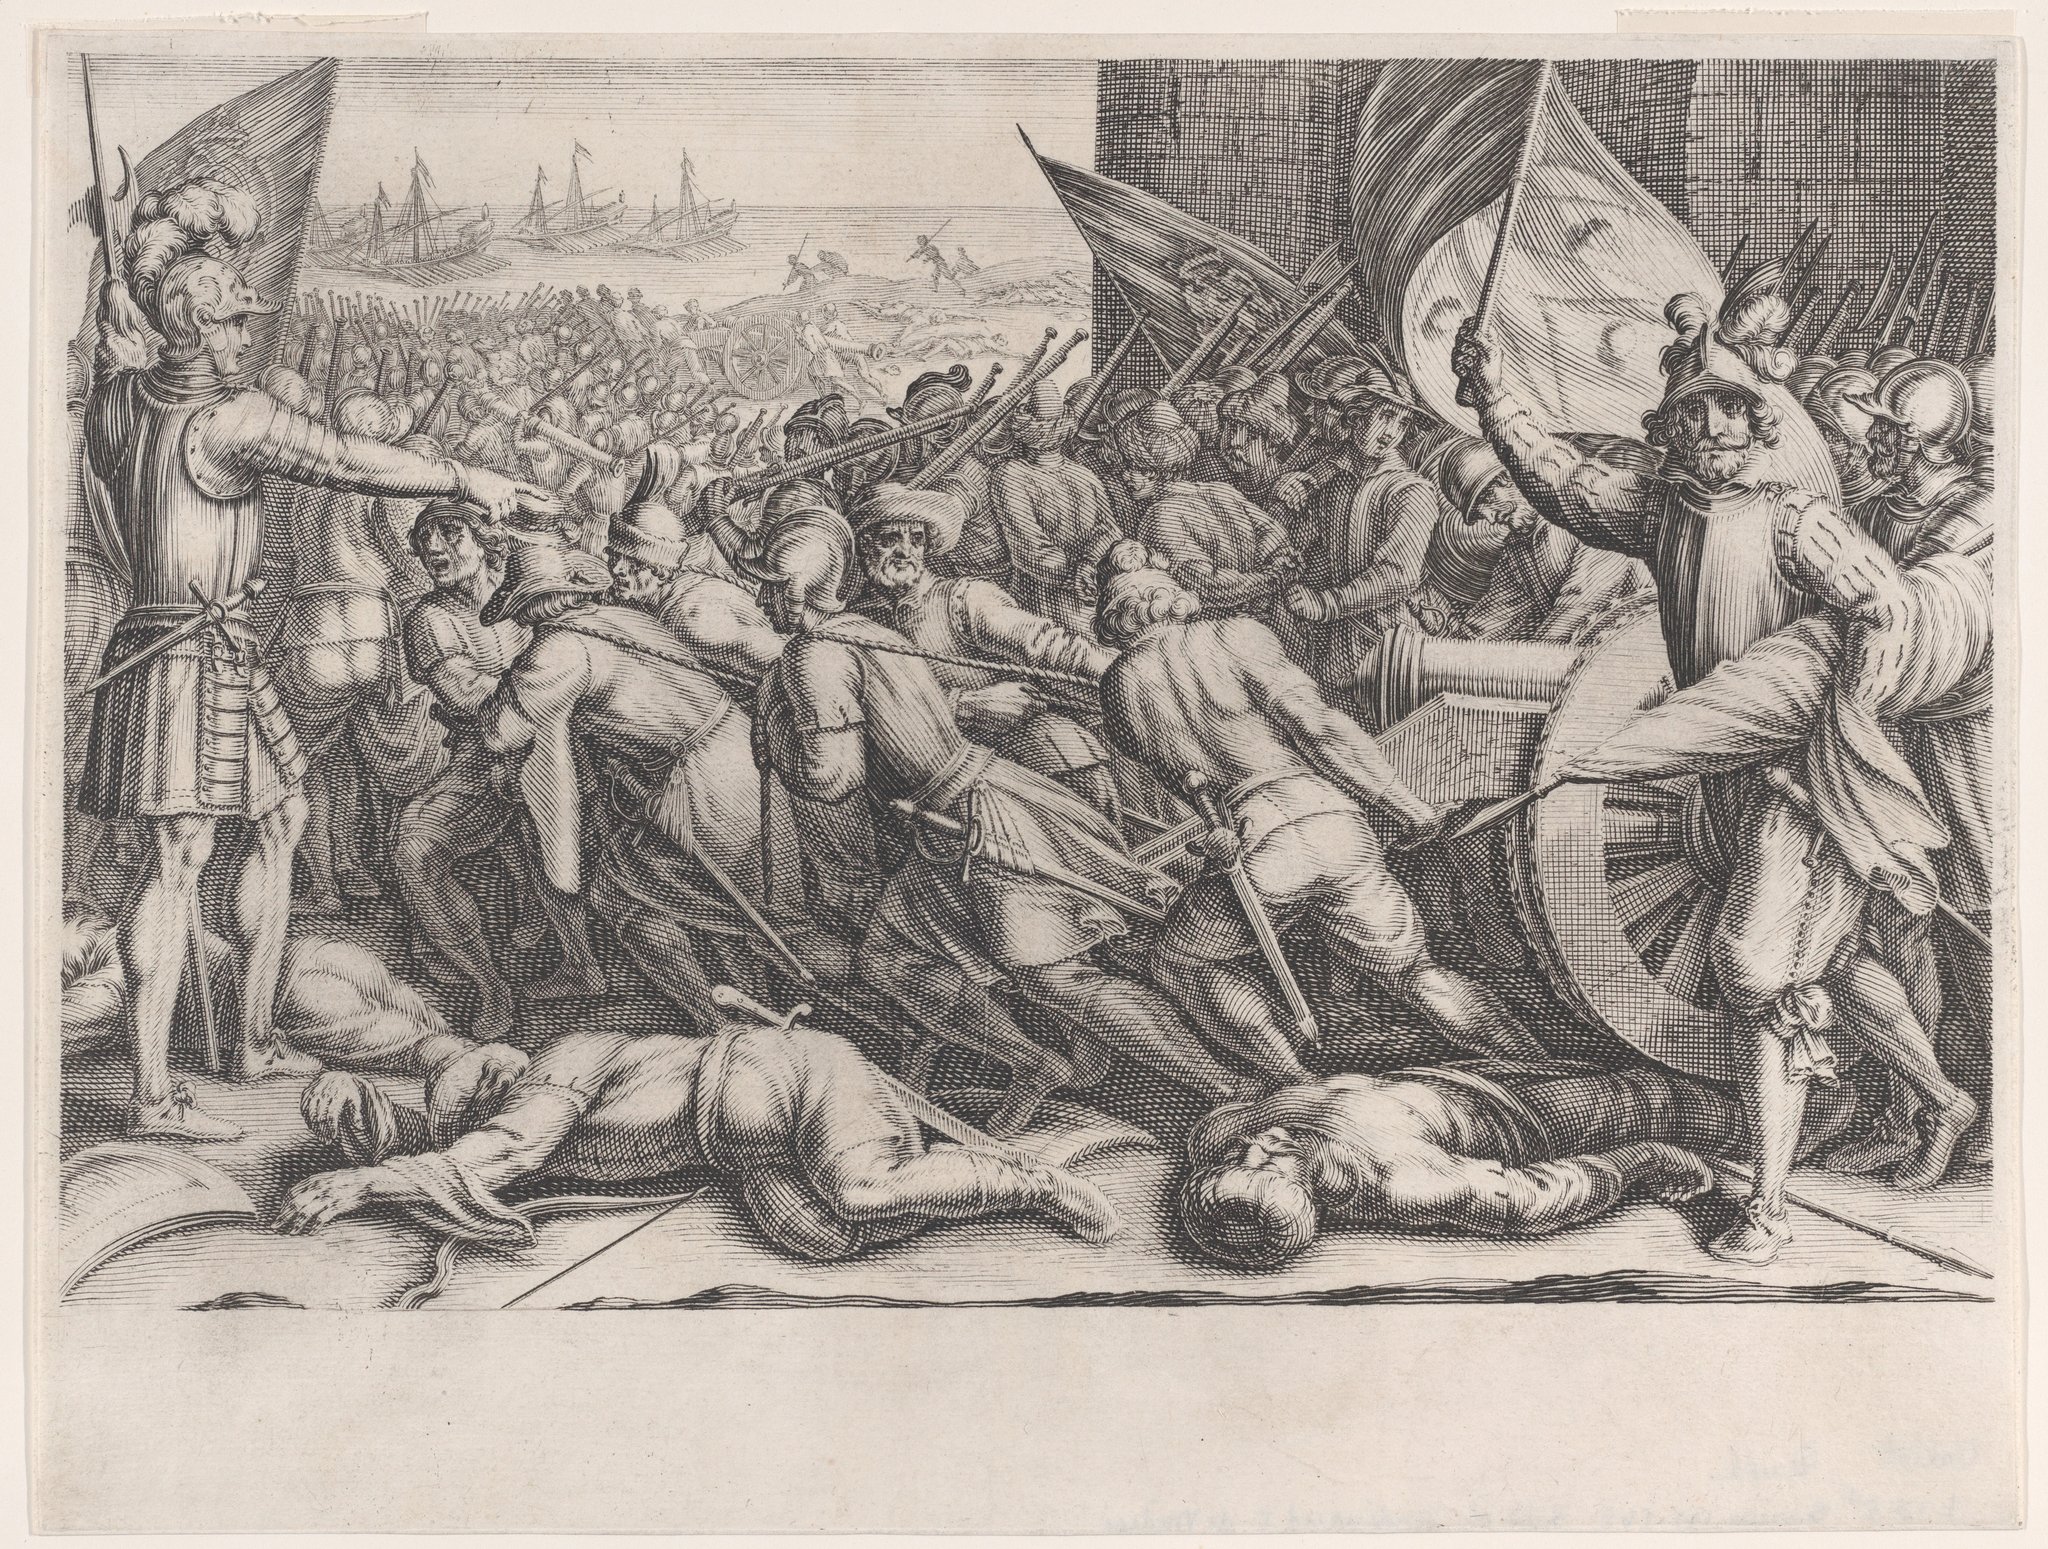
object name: print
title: Rembarquement des Troupes (Embarkation of Troops), from La Vie de Ferdinand Ier de Médicis série appelée aussi Les Batailles des Médicis (The Life of Ferdinand I de'Medici also called The Medici Battles)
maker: jacques callot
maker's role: artist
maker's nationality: french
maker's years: 1592-1635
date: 1614-1620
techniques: engraving